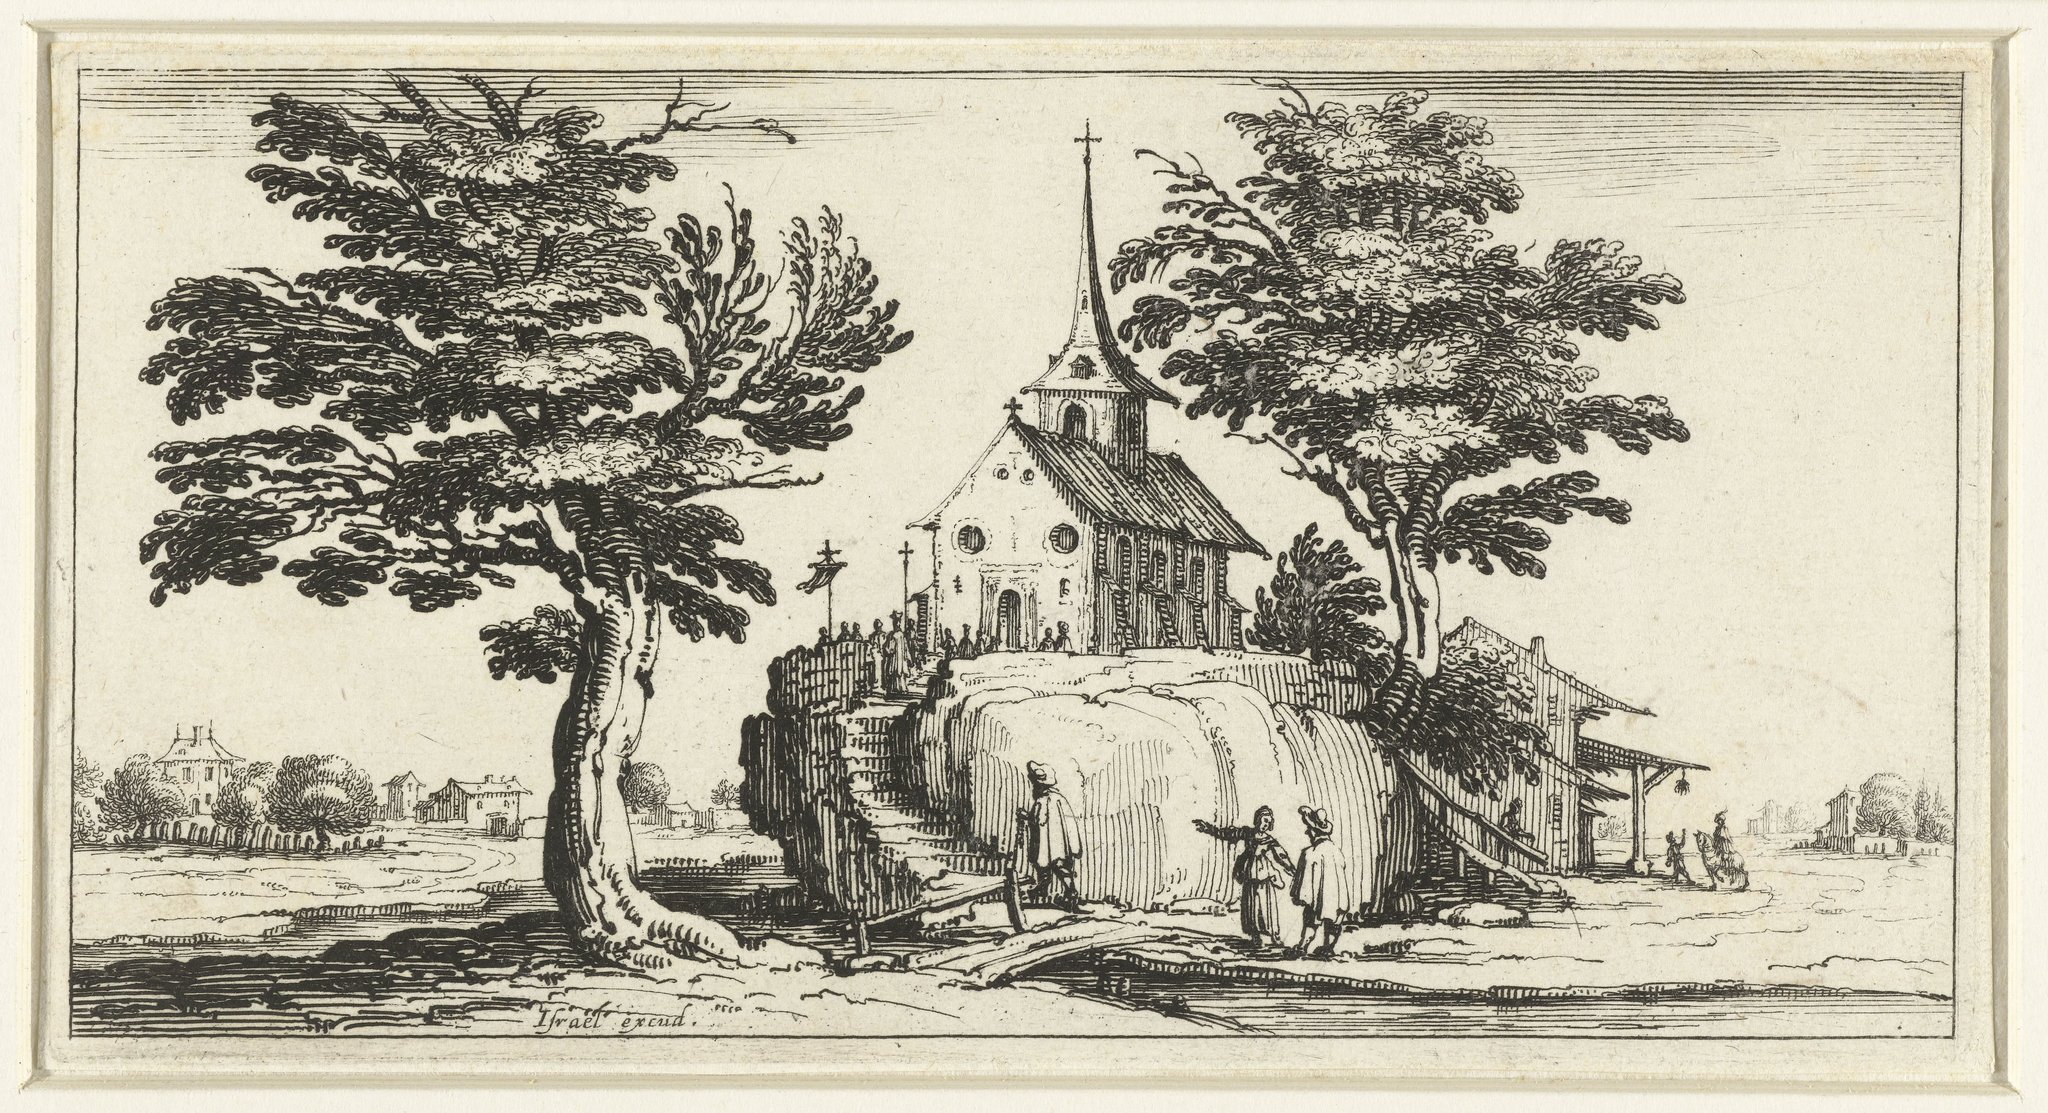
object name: print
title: Divers paisages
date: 1630-1660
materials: paper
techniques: etching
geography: paris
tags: going to church, church (exterior), landscape with other man-made constructions not mentioned above, e.g.: graveyards, playgrounds, etc., rocks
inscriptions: collector's mark: Lugt 240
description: In een landschap met enkele bomen en huizen staat een kerkje op een rots. Drie figuurtjes lopen op het pad dat erheen leidt. Een kleine menigte is verzameld voor de ingang. Deze prent is onderdeel van een serie van 19 prenten (20 incl. titelprent) met landschappen.